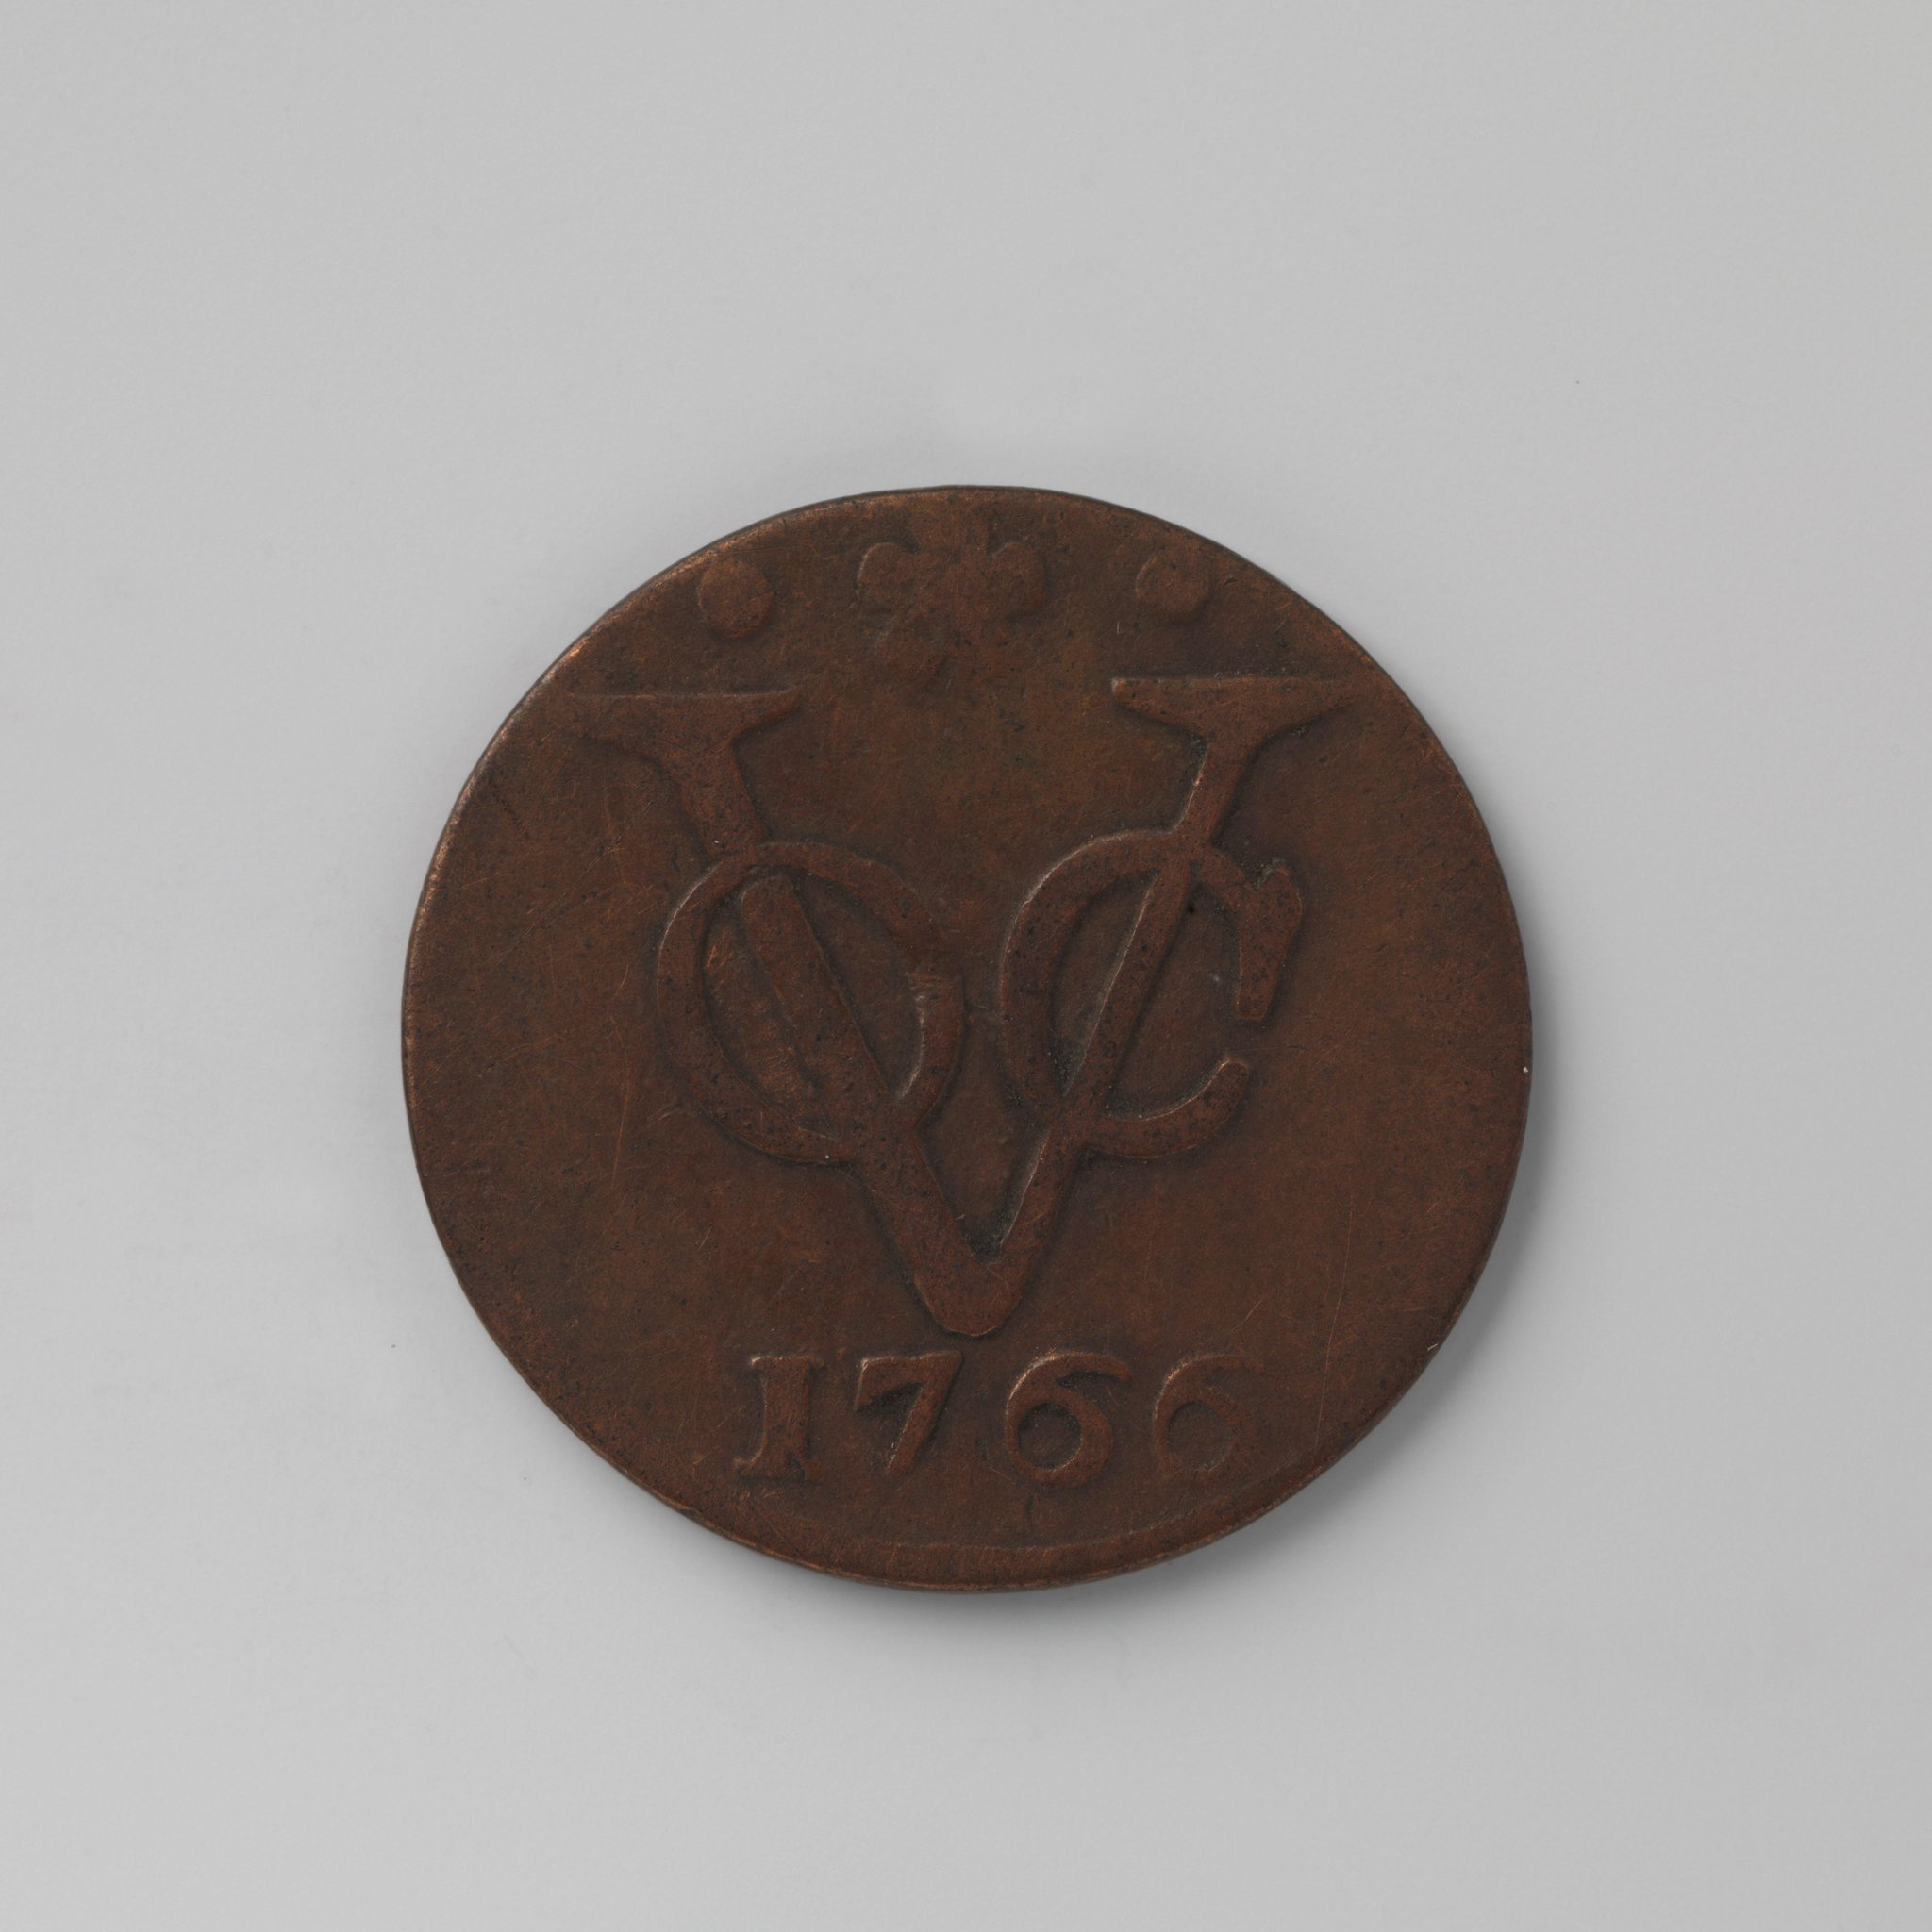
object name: coin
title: Duit van de VOC uit Holland, 1766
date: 1766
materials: copper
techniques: striking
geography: dordrecht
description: Koperen munt. Voorzijde: gekroond wapenschild van Holland. Keerzijde: monogram van de VOC, waarboven muntteken en waaronder jaartal. Gladde rand.